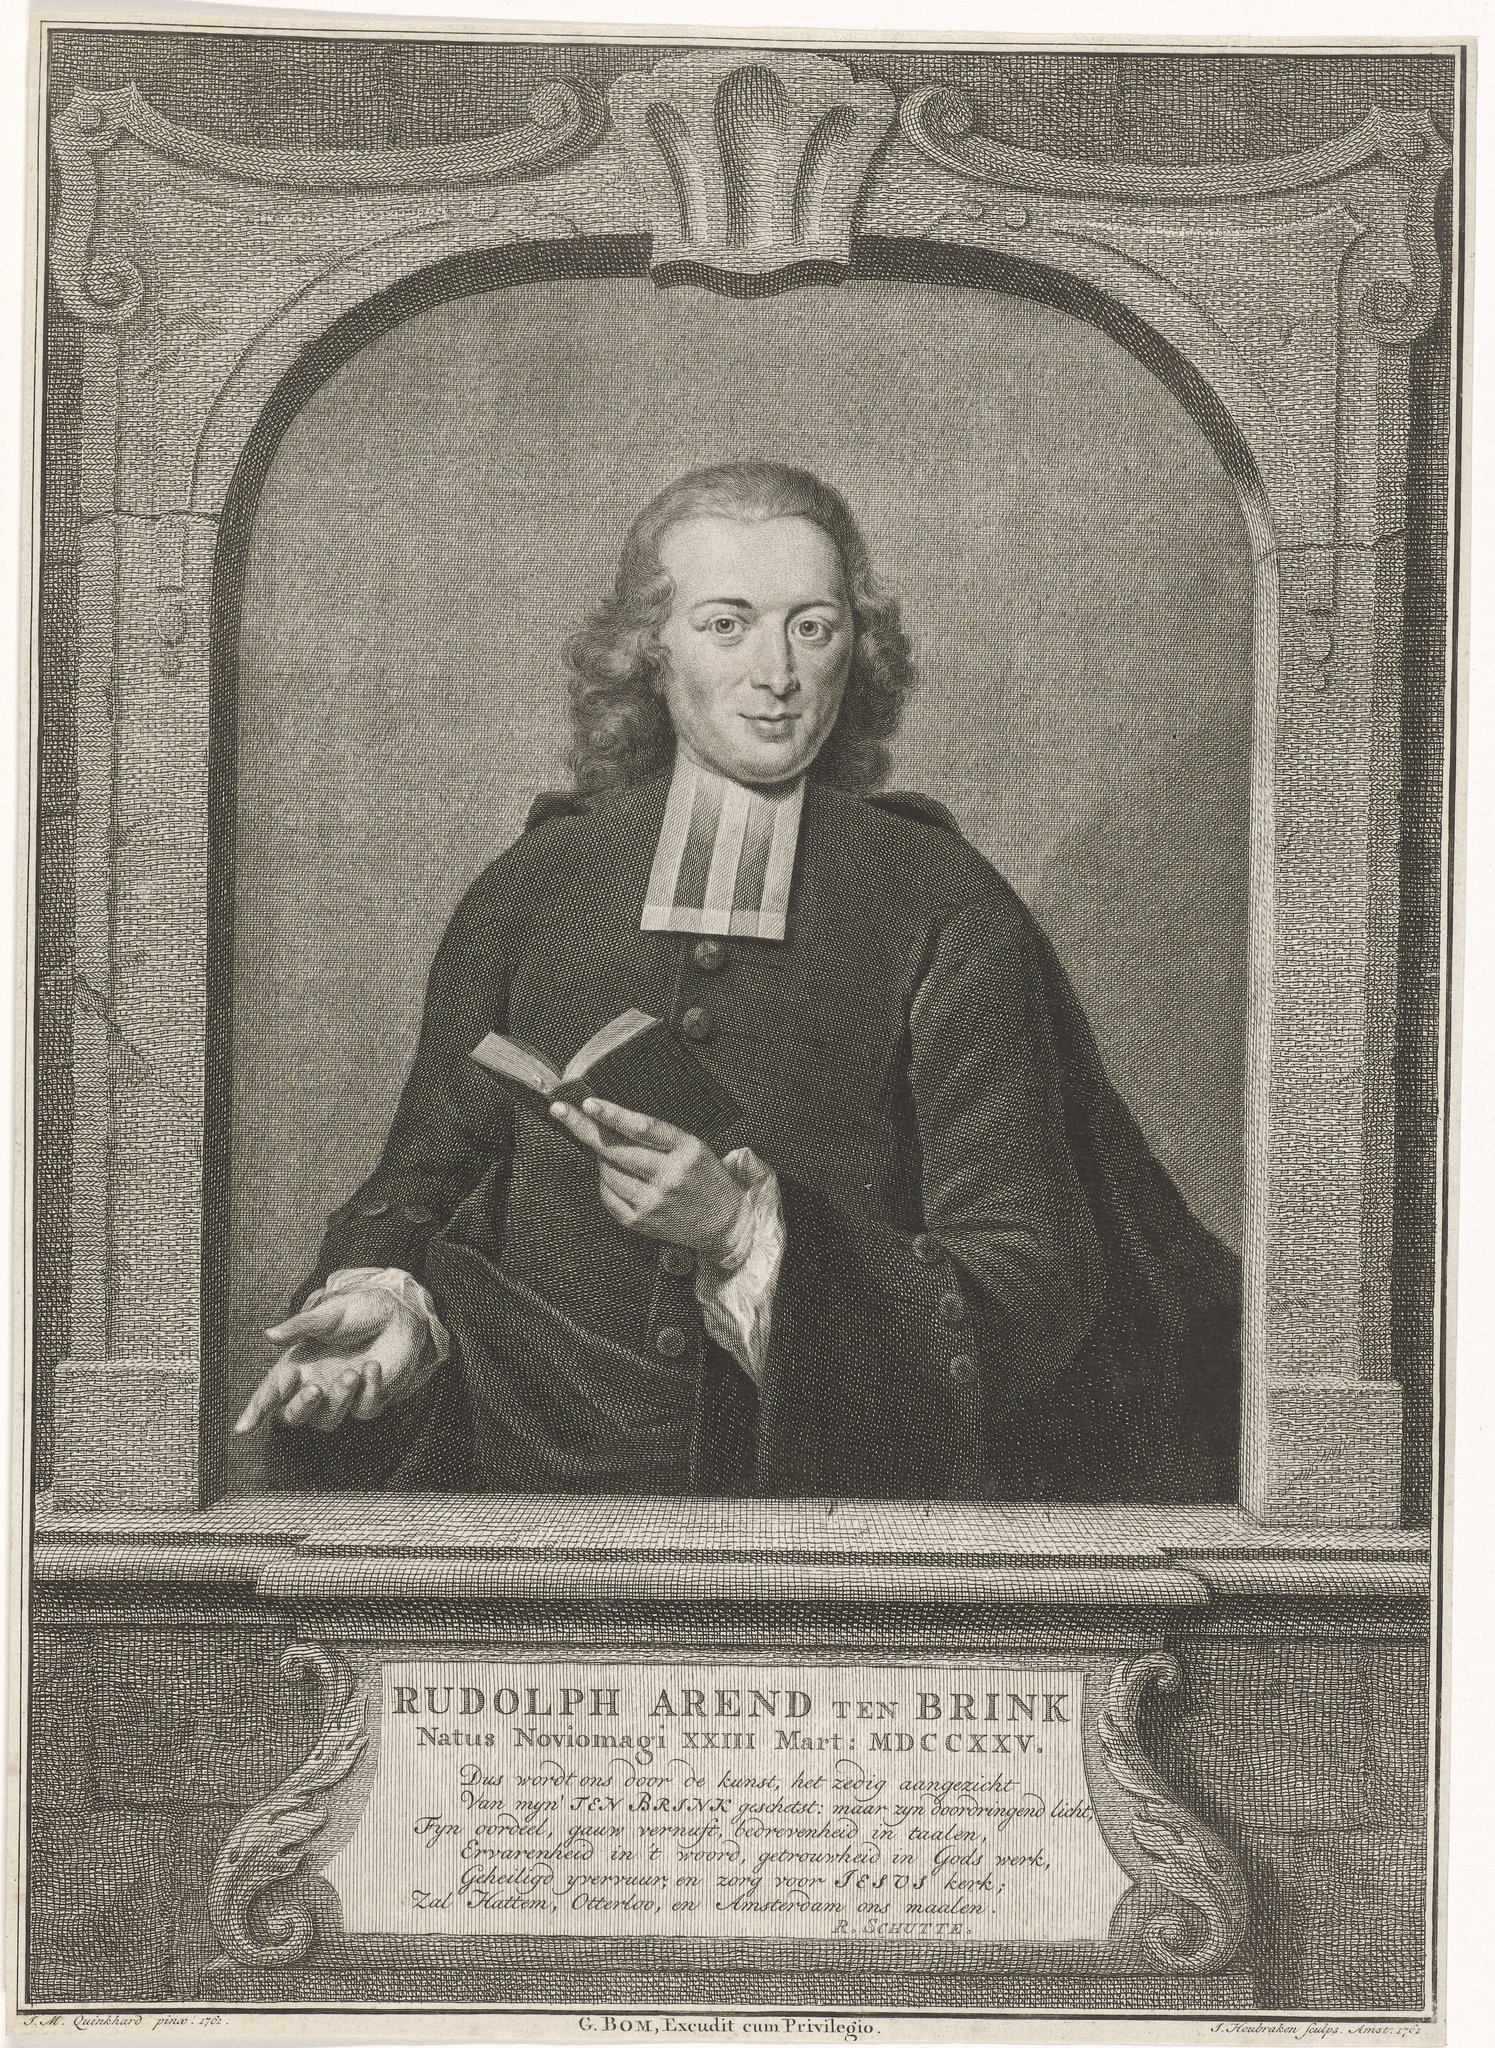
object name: print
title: Portret van Rudolf Arend ten Brink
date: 1761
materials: paper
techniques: engraving, etching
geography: amsterdam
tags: human figure at (open) window, seen from outside - aa - feigned window, the bible as a book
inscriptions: collector's mark: Lugt 2228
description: Portret ten halven lijve van Rudolf Arend ten Brink in een architectonische omlijsting met in zijn linkerhand een bijbel. Onder het portret zijn naam en gegevens in twee regels in het Latijn, met daaronder een zesregelig vers in het Nederlands.